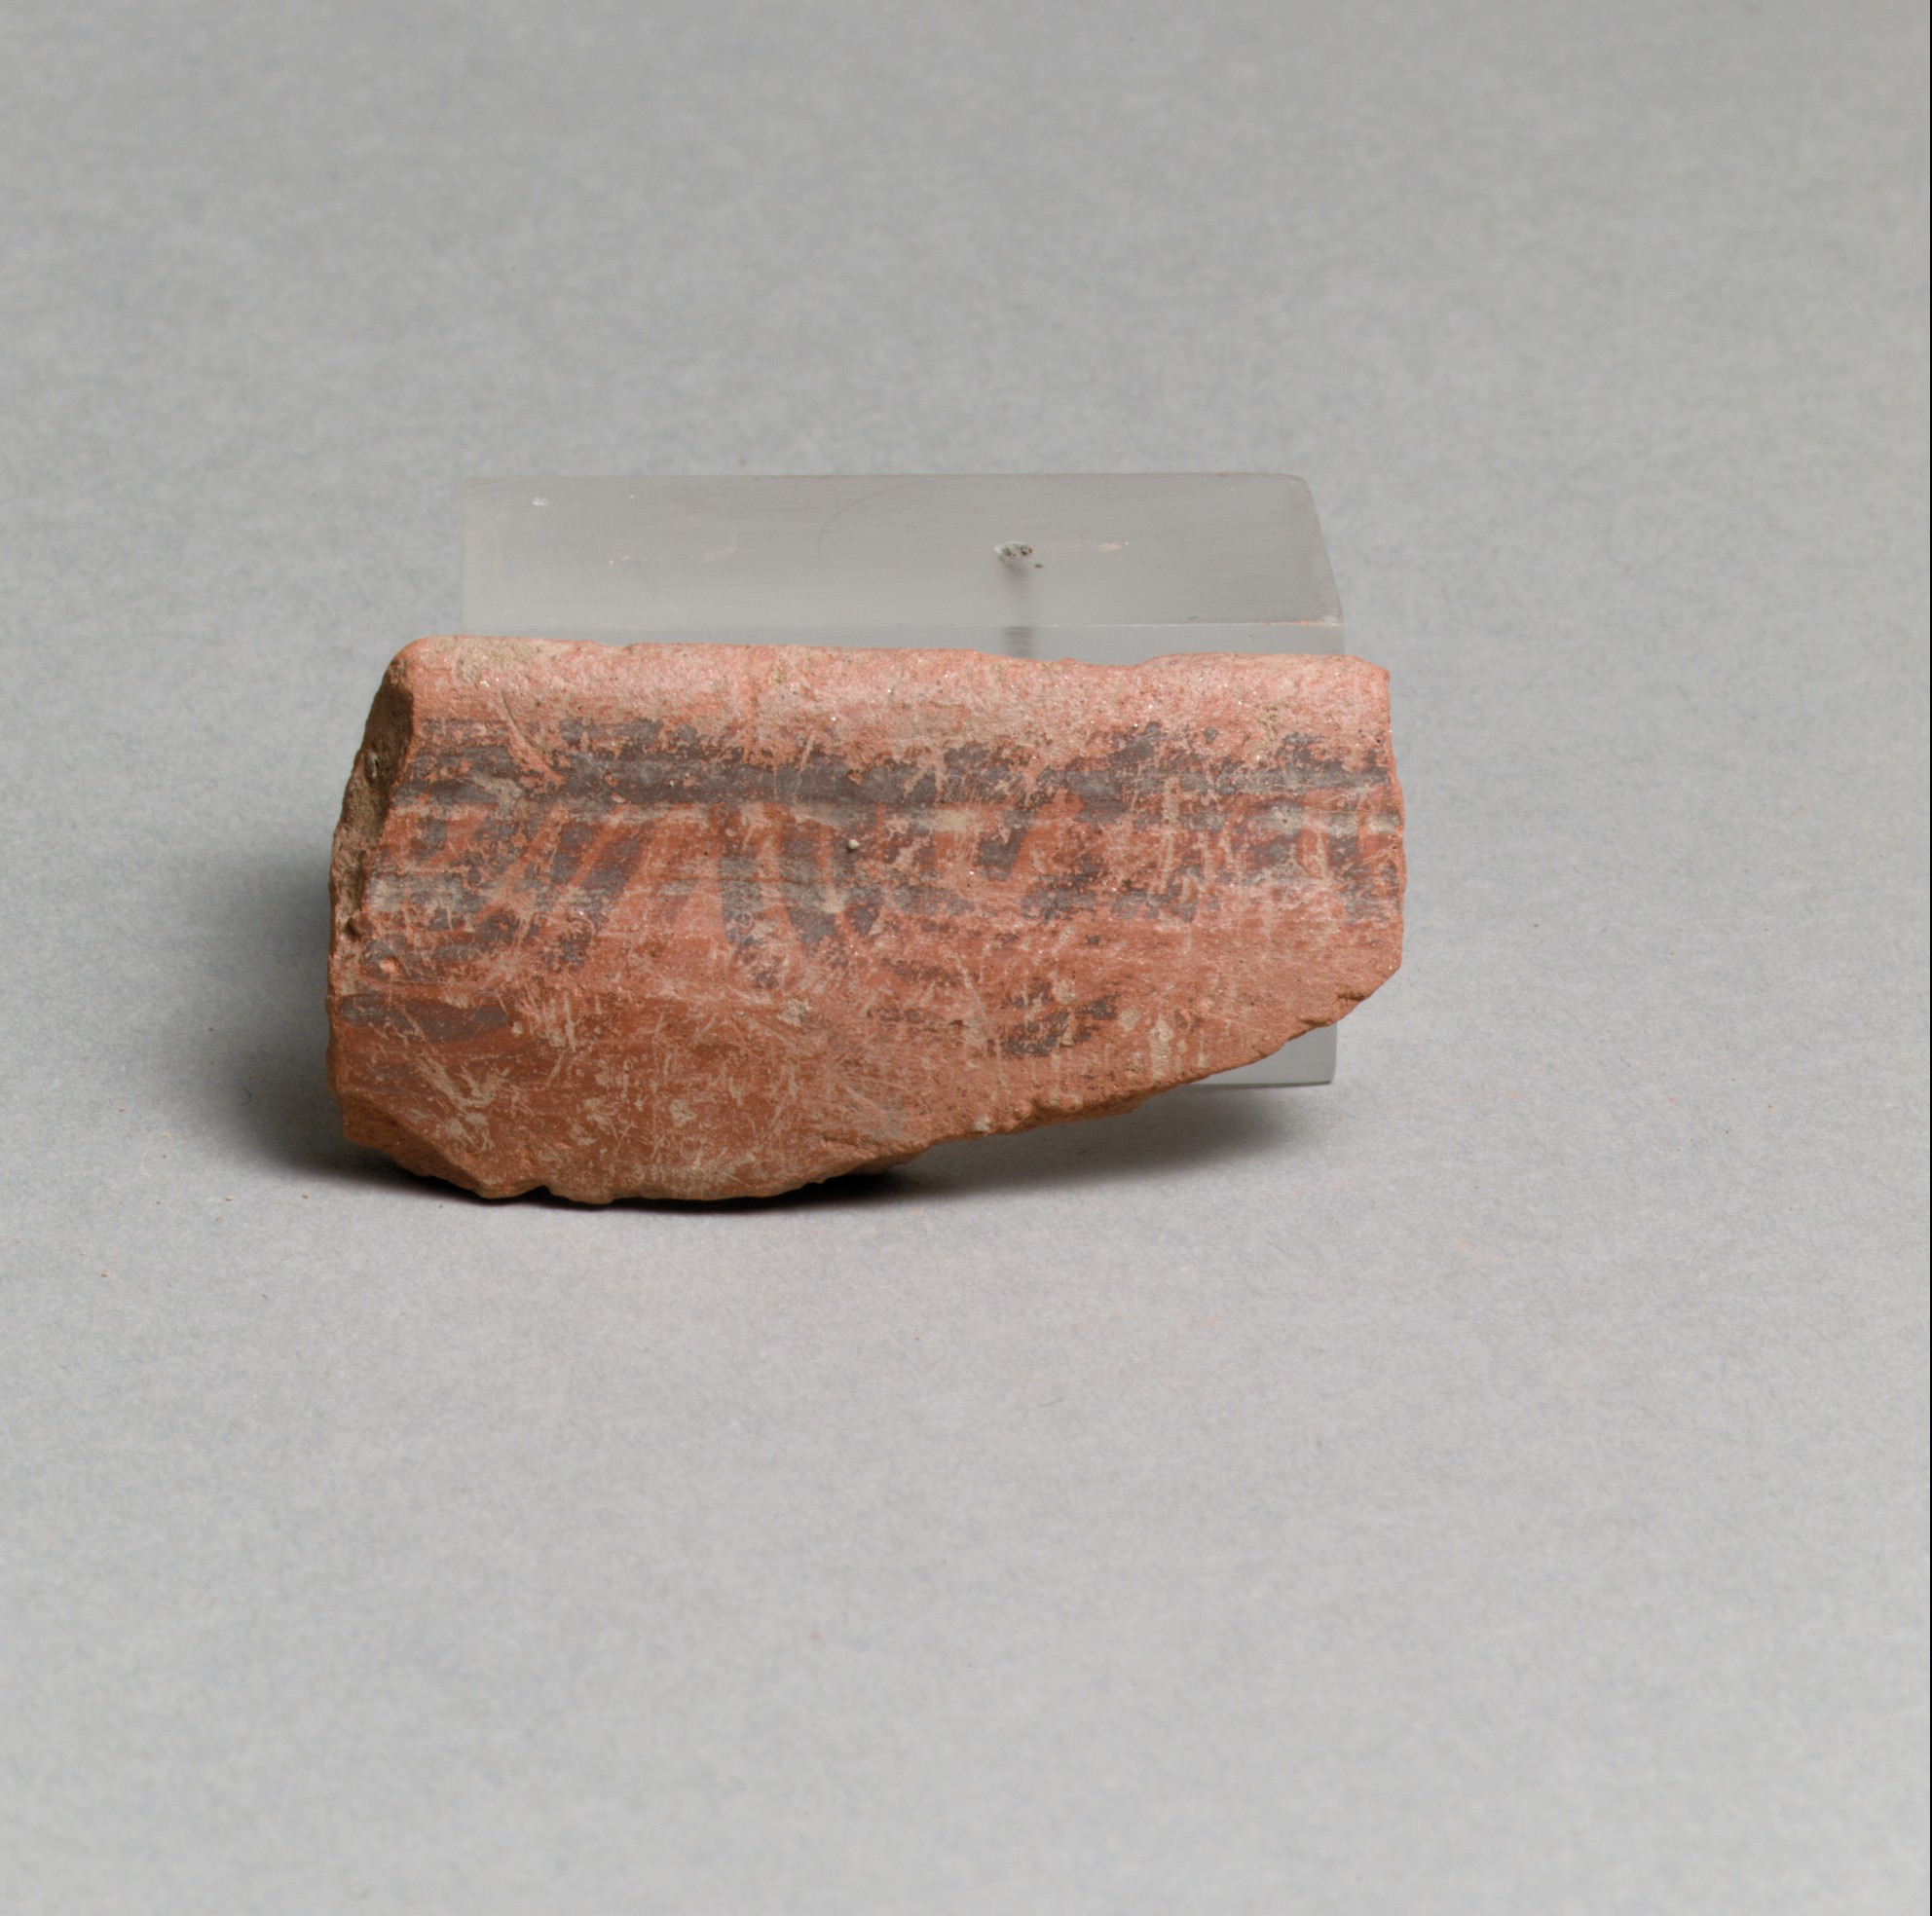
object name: vase fragment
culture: greek or lydian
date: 1050-700 BCE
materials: terracotta